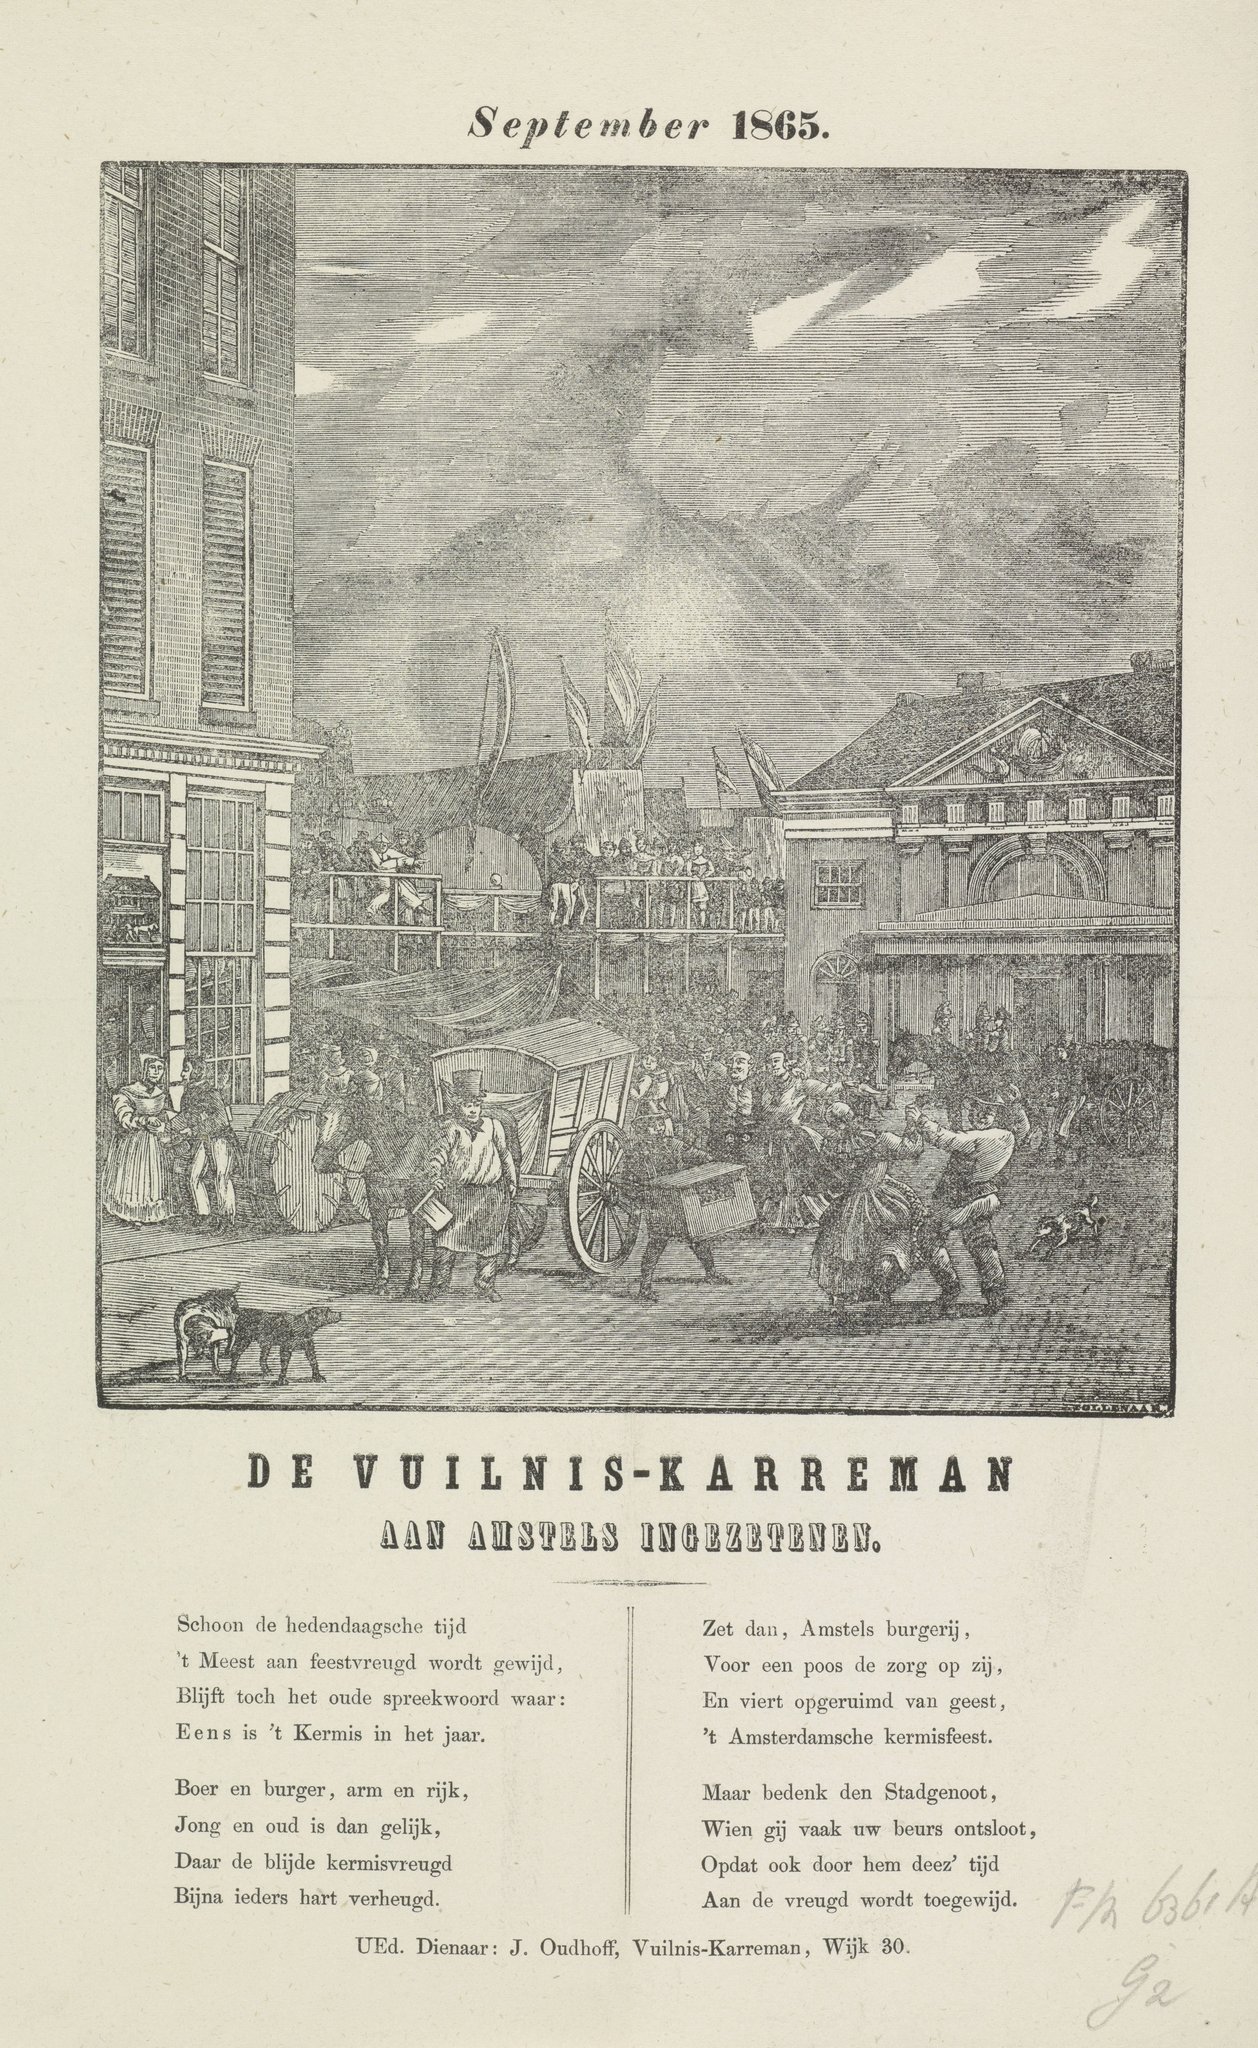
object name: fair print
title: De Vuilnis-karreman aan Amstels Ingezetenen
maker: dirk wijbrand tollenaar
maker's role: print maker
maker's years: 1808-1858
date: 1865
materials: paper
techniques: letterpress printing, engraving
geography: amsterdam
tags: street, garbage collection, amsterdam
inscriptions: collector's mark: Lugt 2228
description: Kermisprent van de Amsterdamse vuilnismannen voor het jaar 1865. Gezicht op de kermis op de Botermarkt met de oude Waag. Op de markt twee vuilniskarren. Met gedicht in twee kolommen. Van de vuilniskarman in de wijk no. 30: J. Oudhoff.